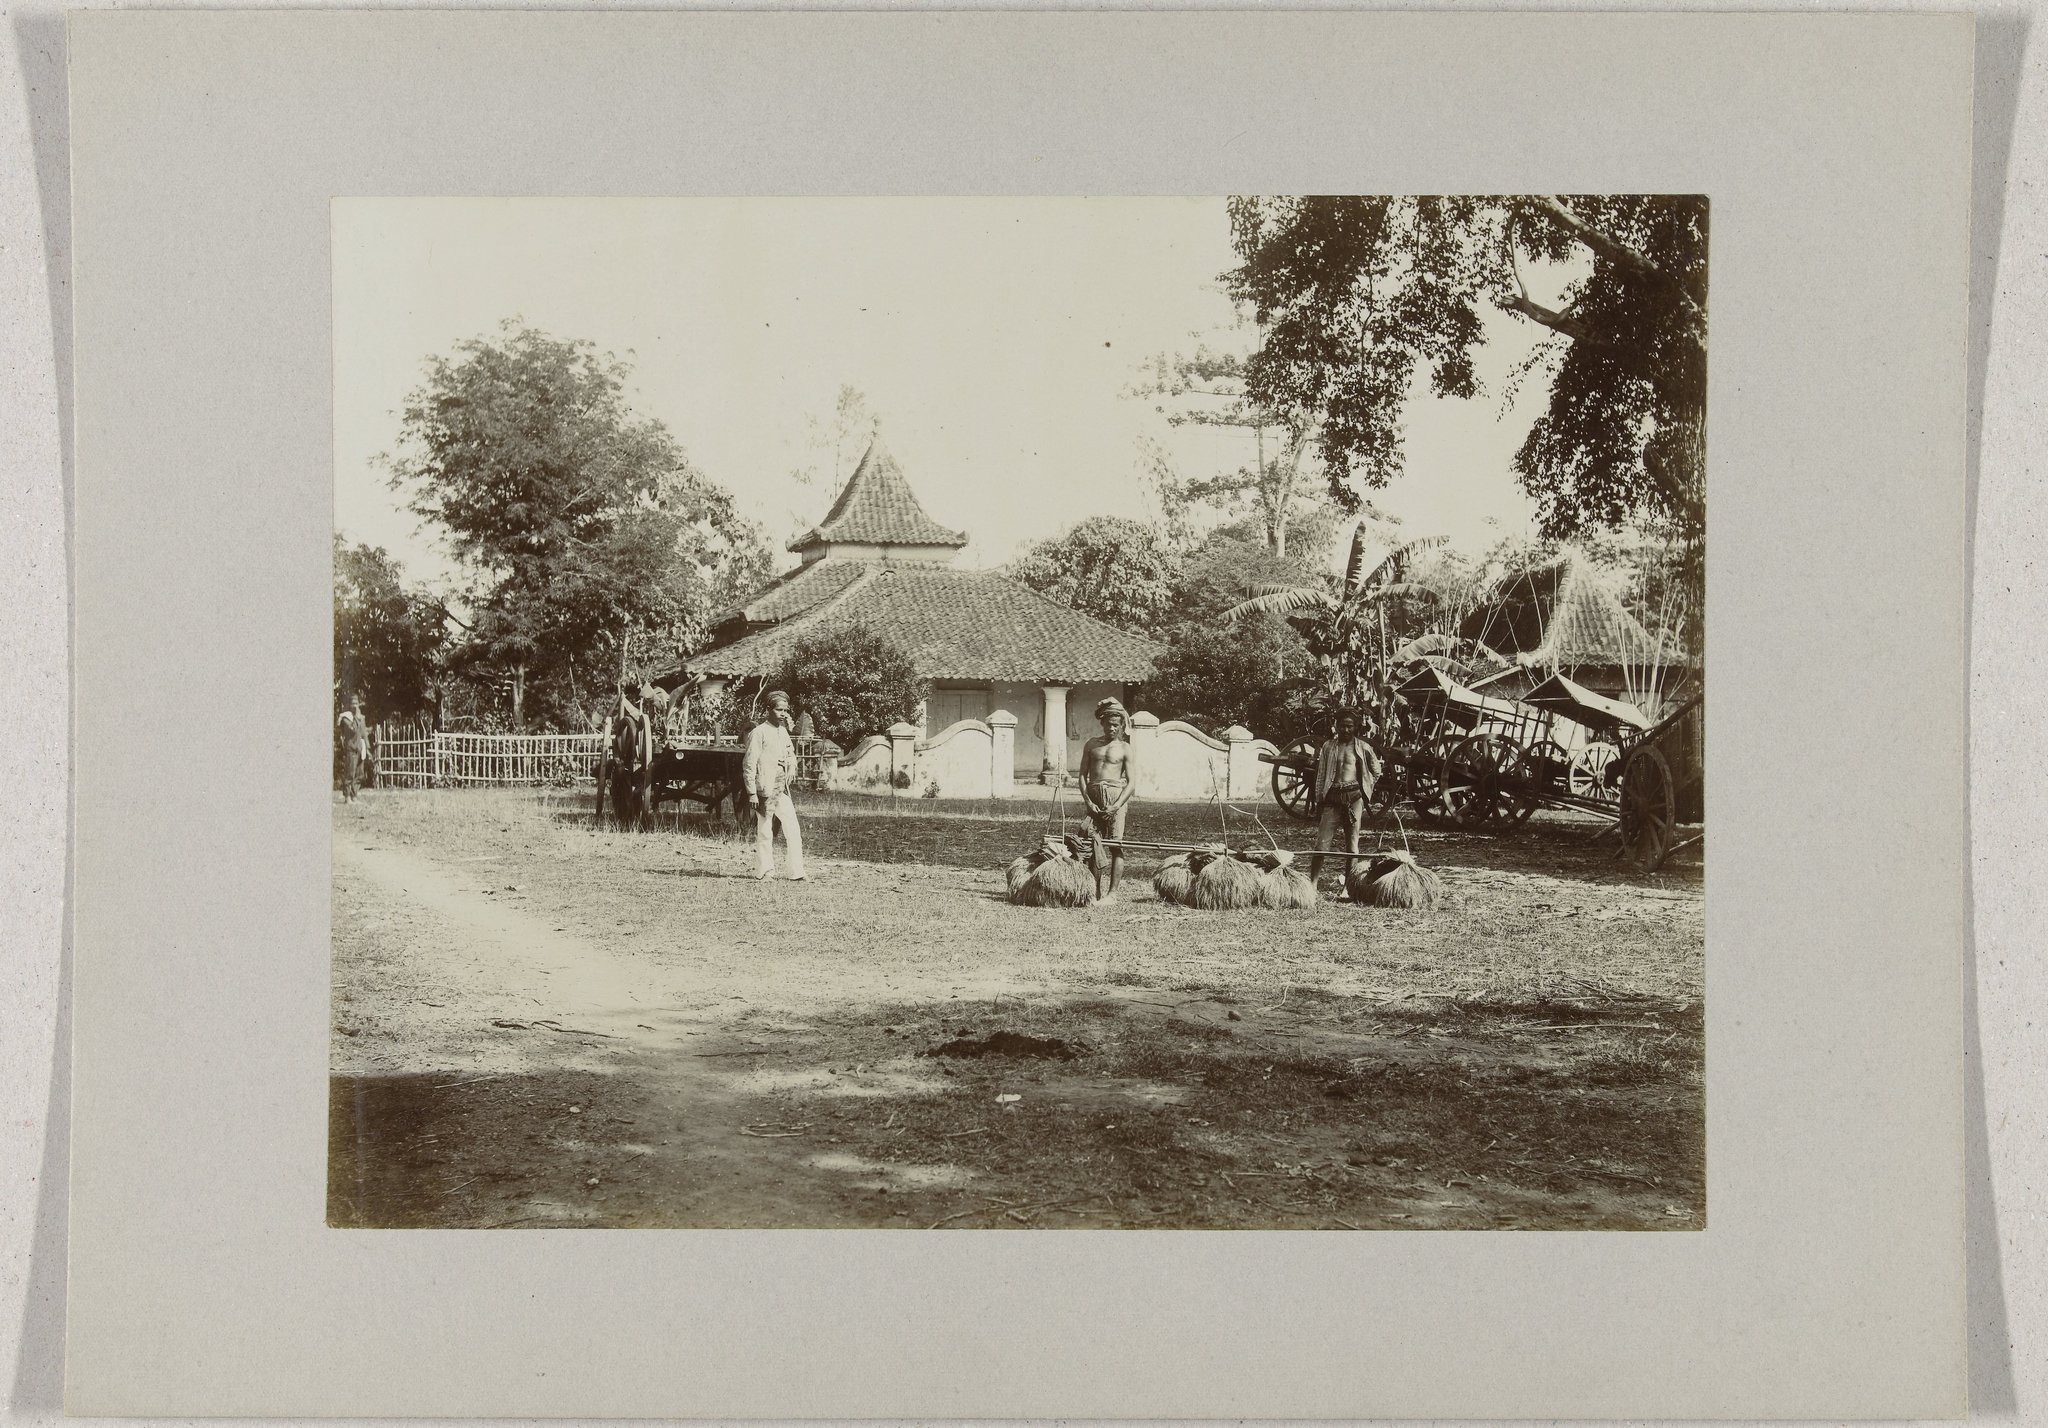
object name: photograph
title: Mannen nabij een huis in Bandung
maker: Anonymous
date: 1895-1915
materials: cardboard, paper, photographic support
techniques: gelatin silver print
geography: dutch east indies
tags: indonesia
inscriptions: annotation: ‘61. In 't Bandoengsche’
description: Mannen nabij een huis, Bandoeng, Nederlands-Indië